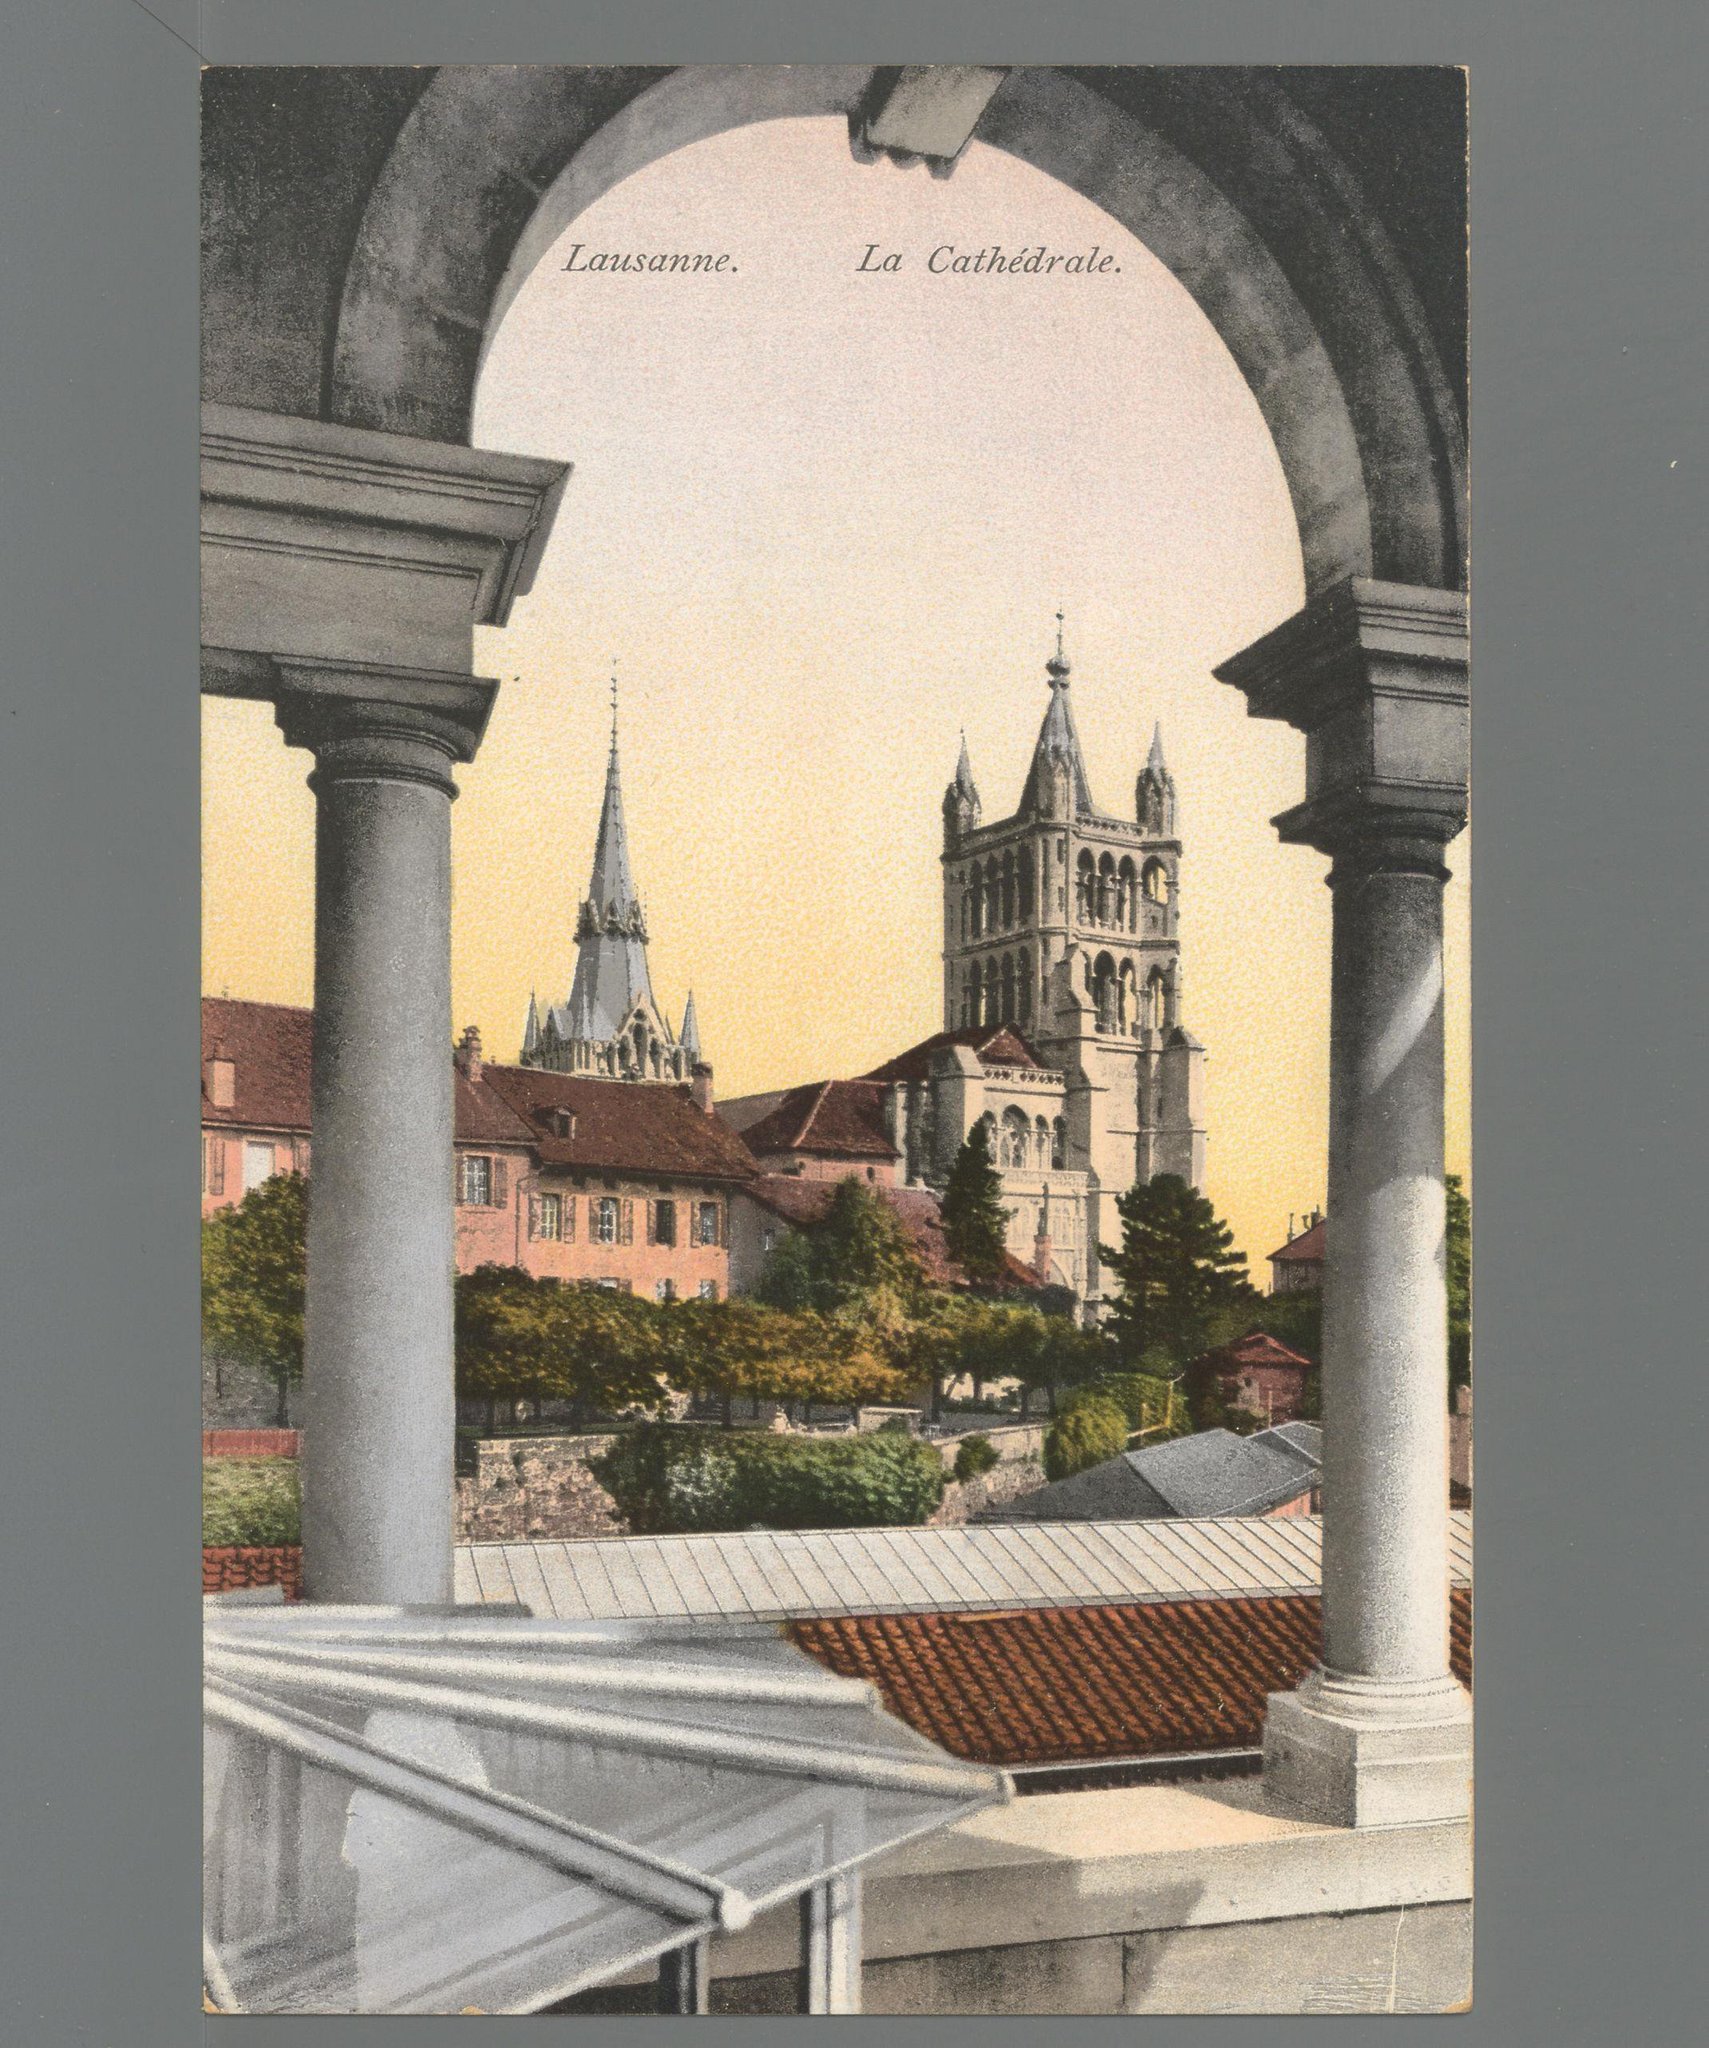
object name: ansichtkaart, prentbriefkaart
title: Lausanne. La Cathédrale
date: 1905-1920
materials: cardboard, photographic process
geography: lausanne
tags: city-view, and landscape with man-made constructions, church (exterior)